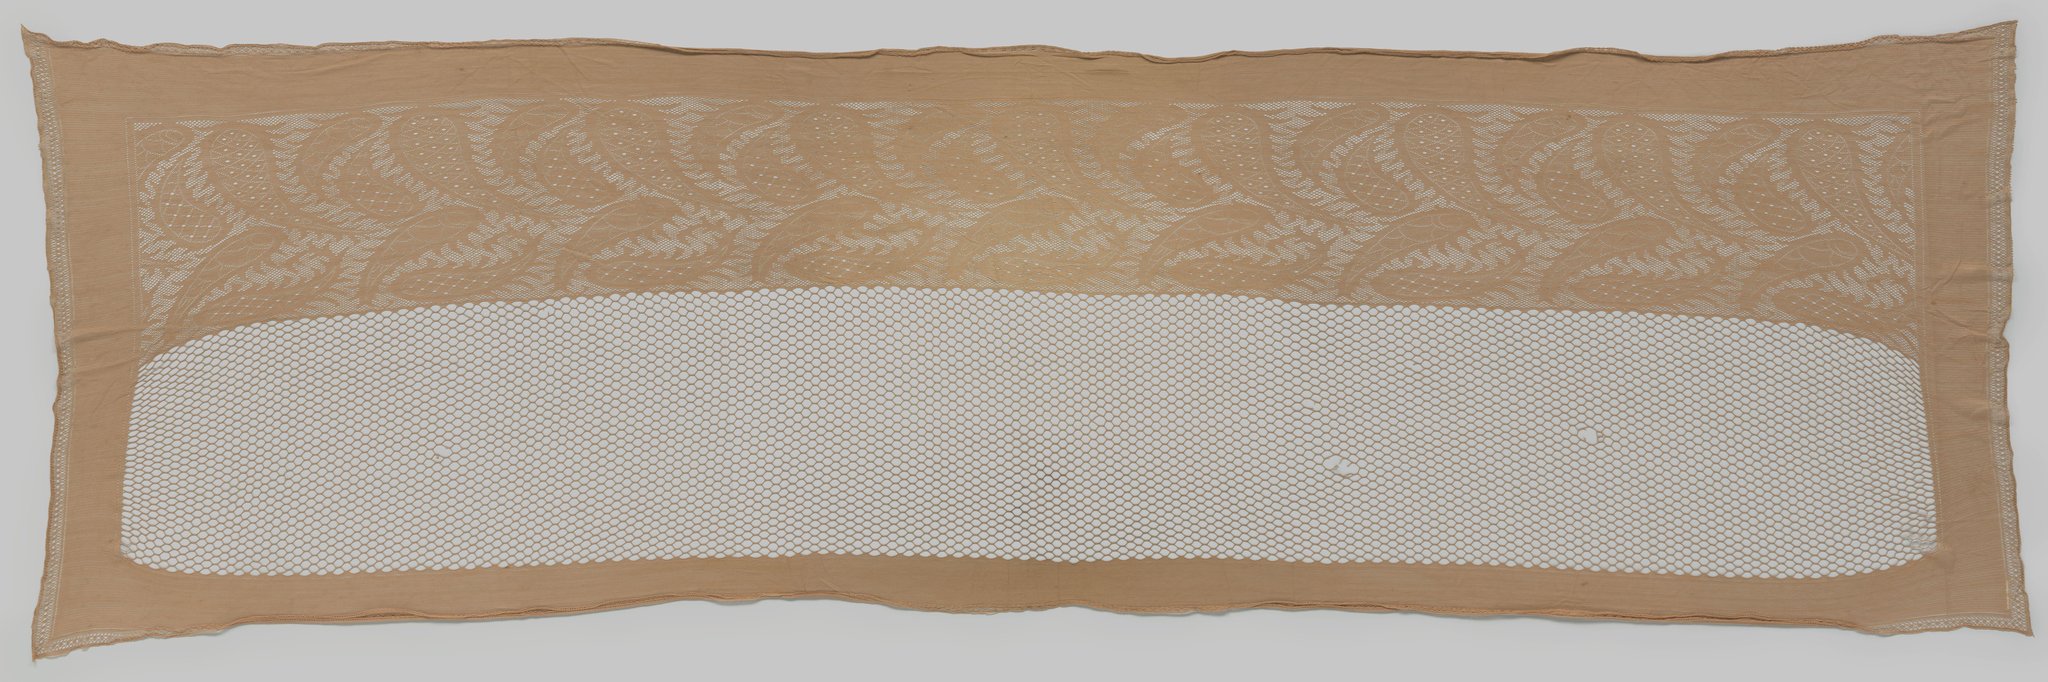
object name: clothing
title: Langwerpige sjaal van mokkakleurige zijden tricot met een brede baan opengewerkte honinggraatmotief en een baan met een strooimotief van bota's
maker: Anonymous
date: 1910-1920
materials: silk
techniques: knitting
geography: netherlands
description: Langwerpige sjaal van mokkakleurige gebreide zijden tricot met een brede baan opengewerkte honinggraatmotief en een baan met een strooimotief van bota's, binnen een effen lijst, afgezet met een smalle opengewerkte rand.